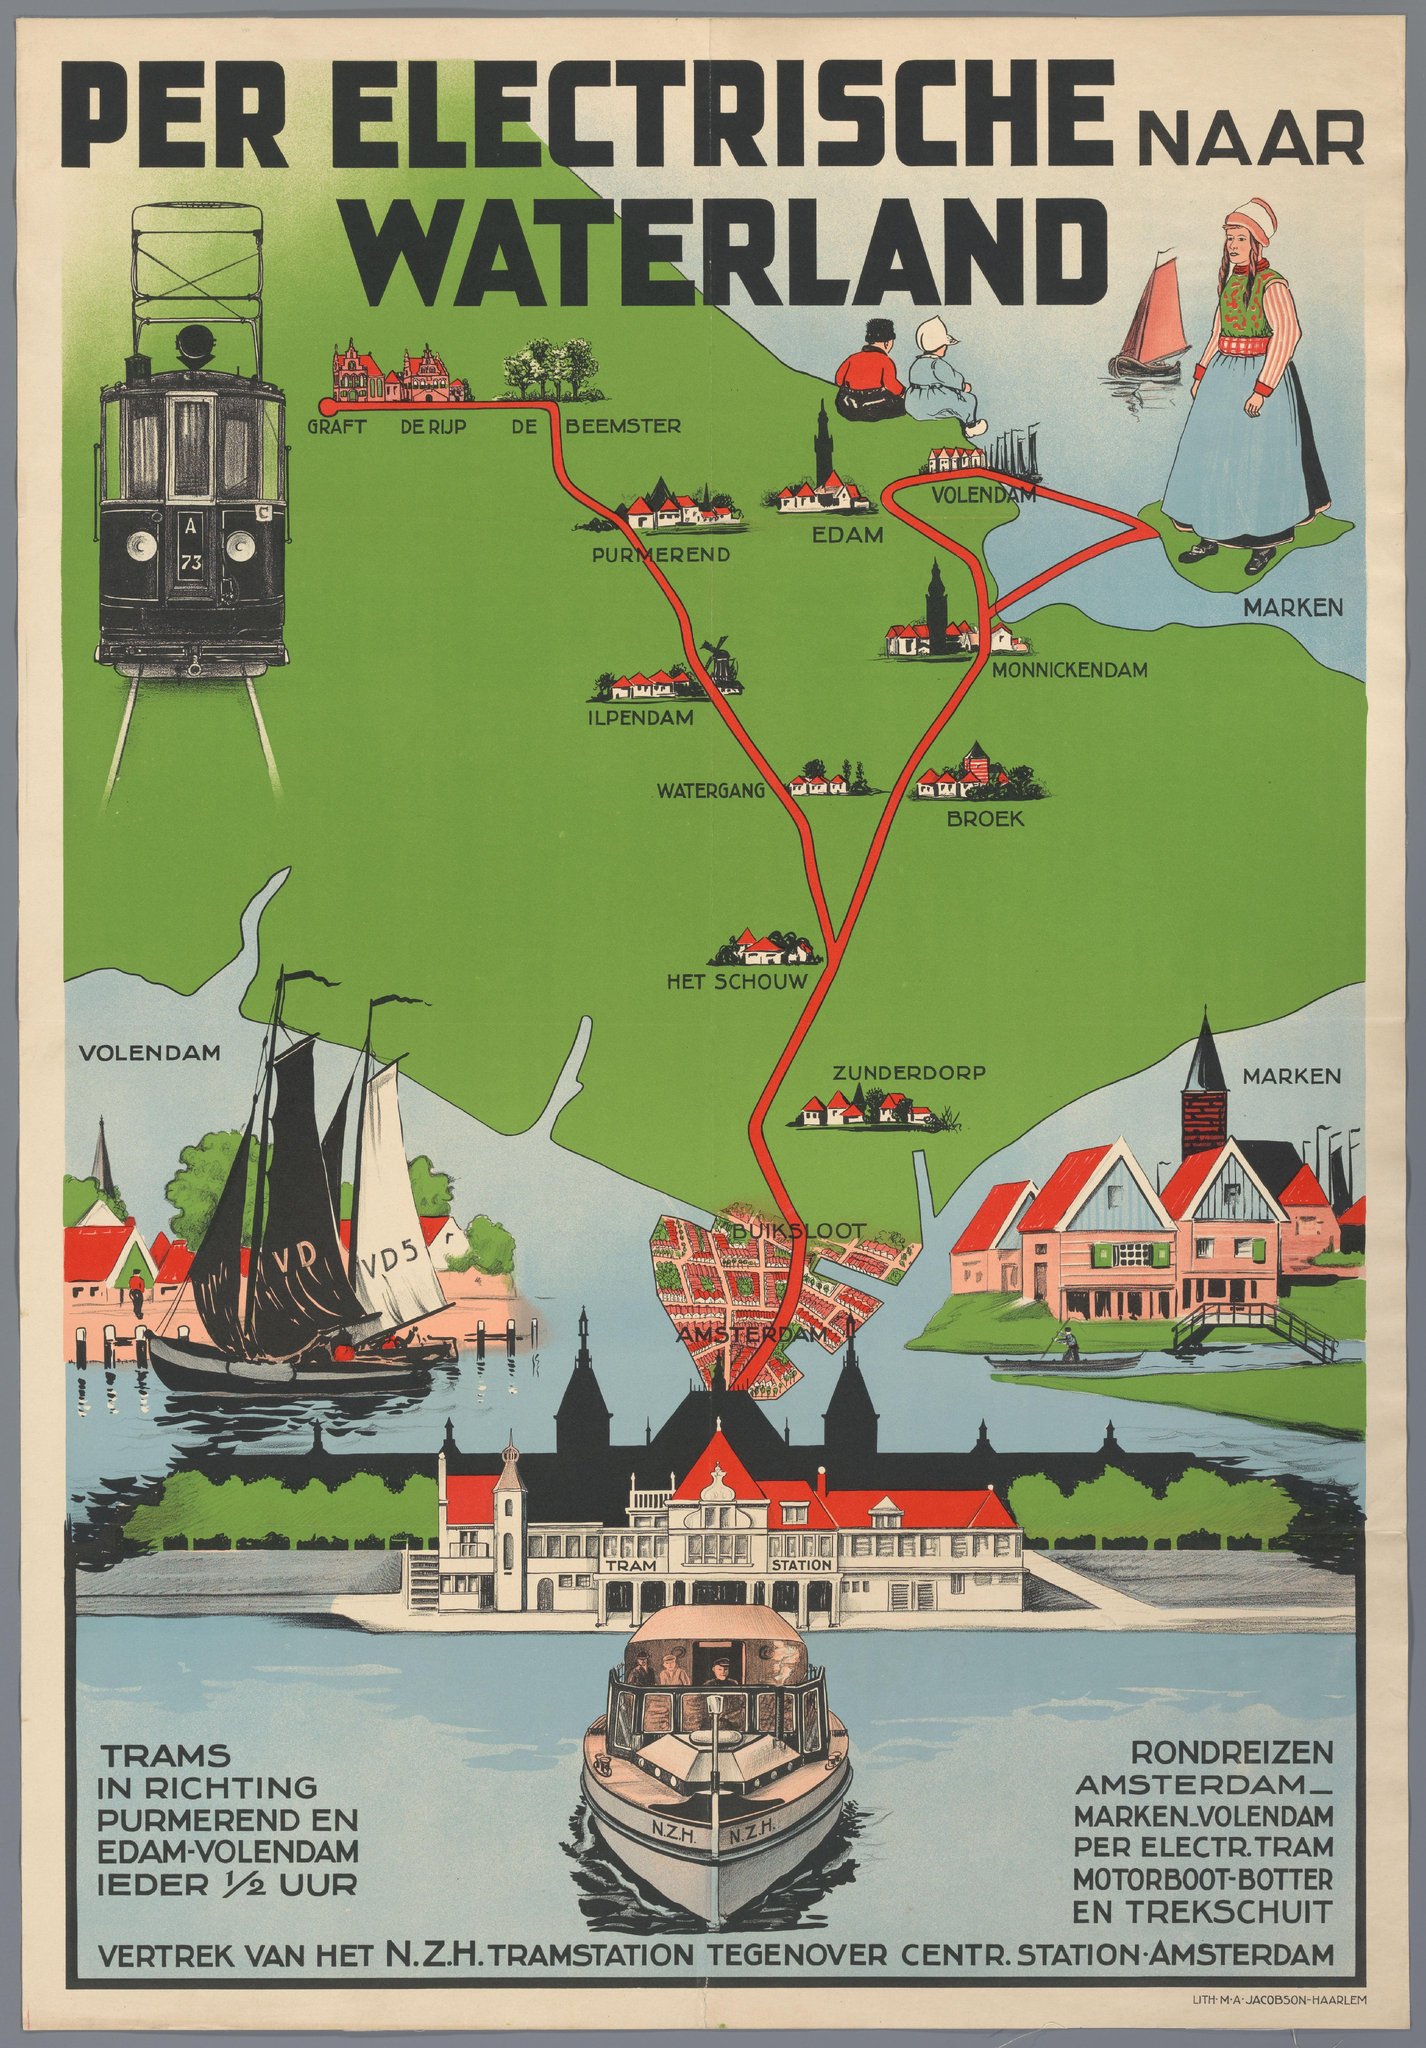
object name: poster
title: Per electrische naar Waterland. Tram richting Purmerend, Edam-Volendam ieder 1/2 uur. Rondreizen Amsterdam - Marken- Volendam per elctr. tram - motorboot- botter en trekschuit. Vertrek van het N.Z.H. tramstation regenover het Centraal Station Amsterdam.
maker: Anonymous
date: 1932-1945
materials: paper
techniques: lithograph